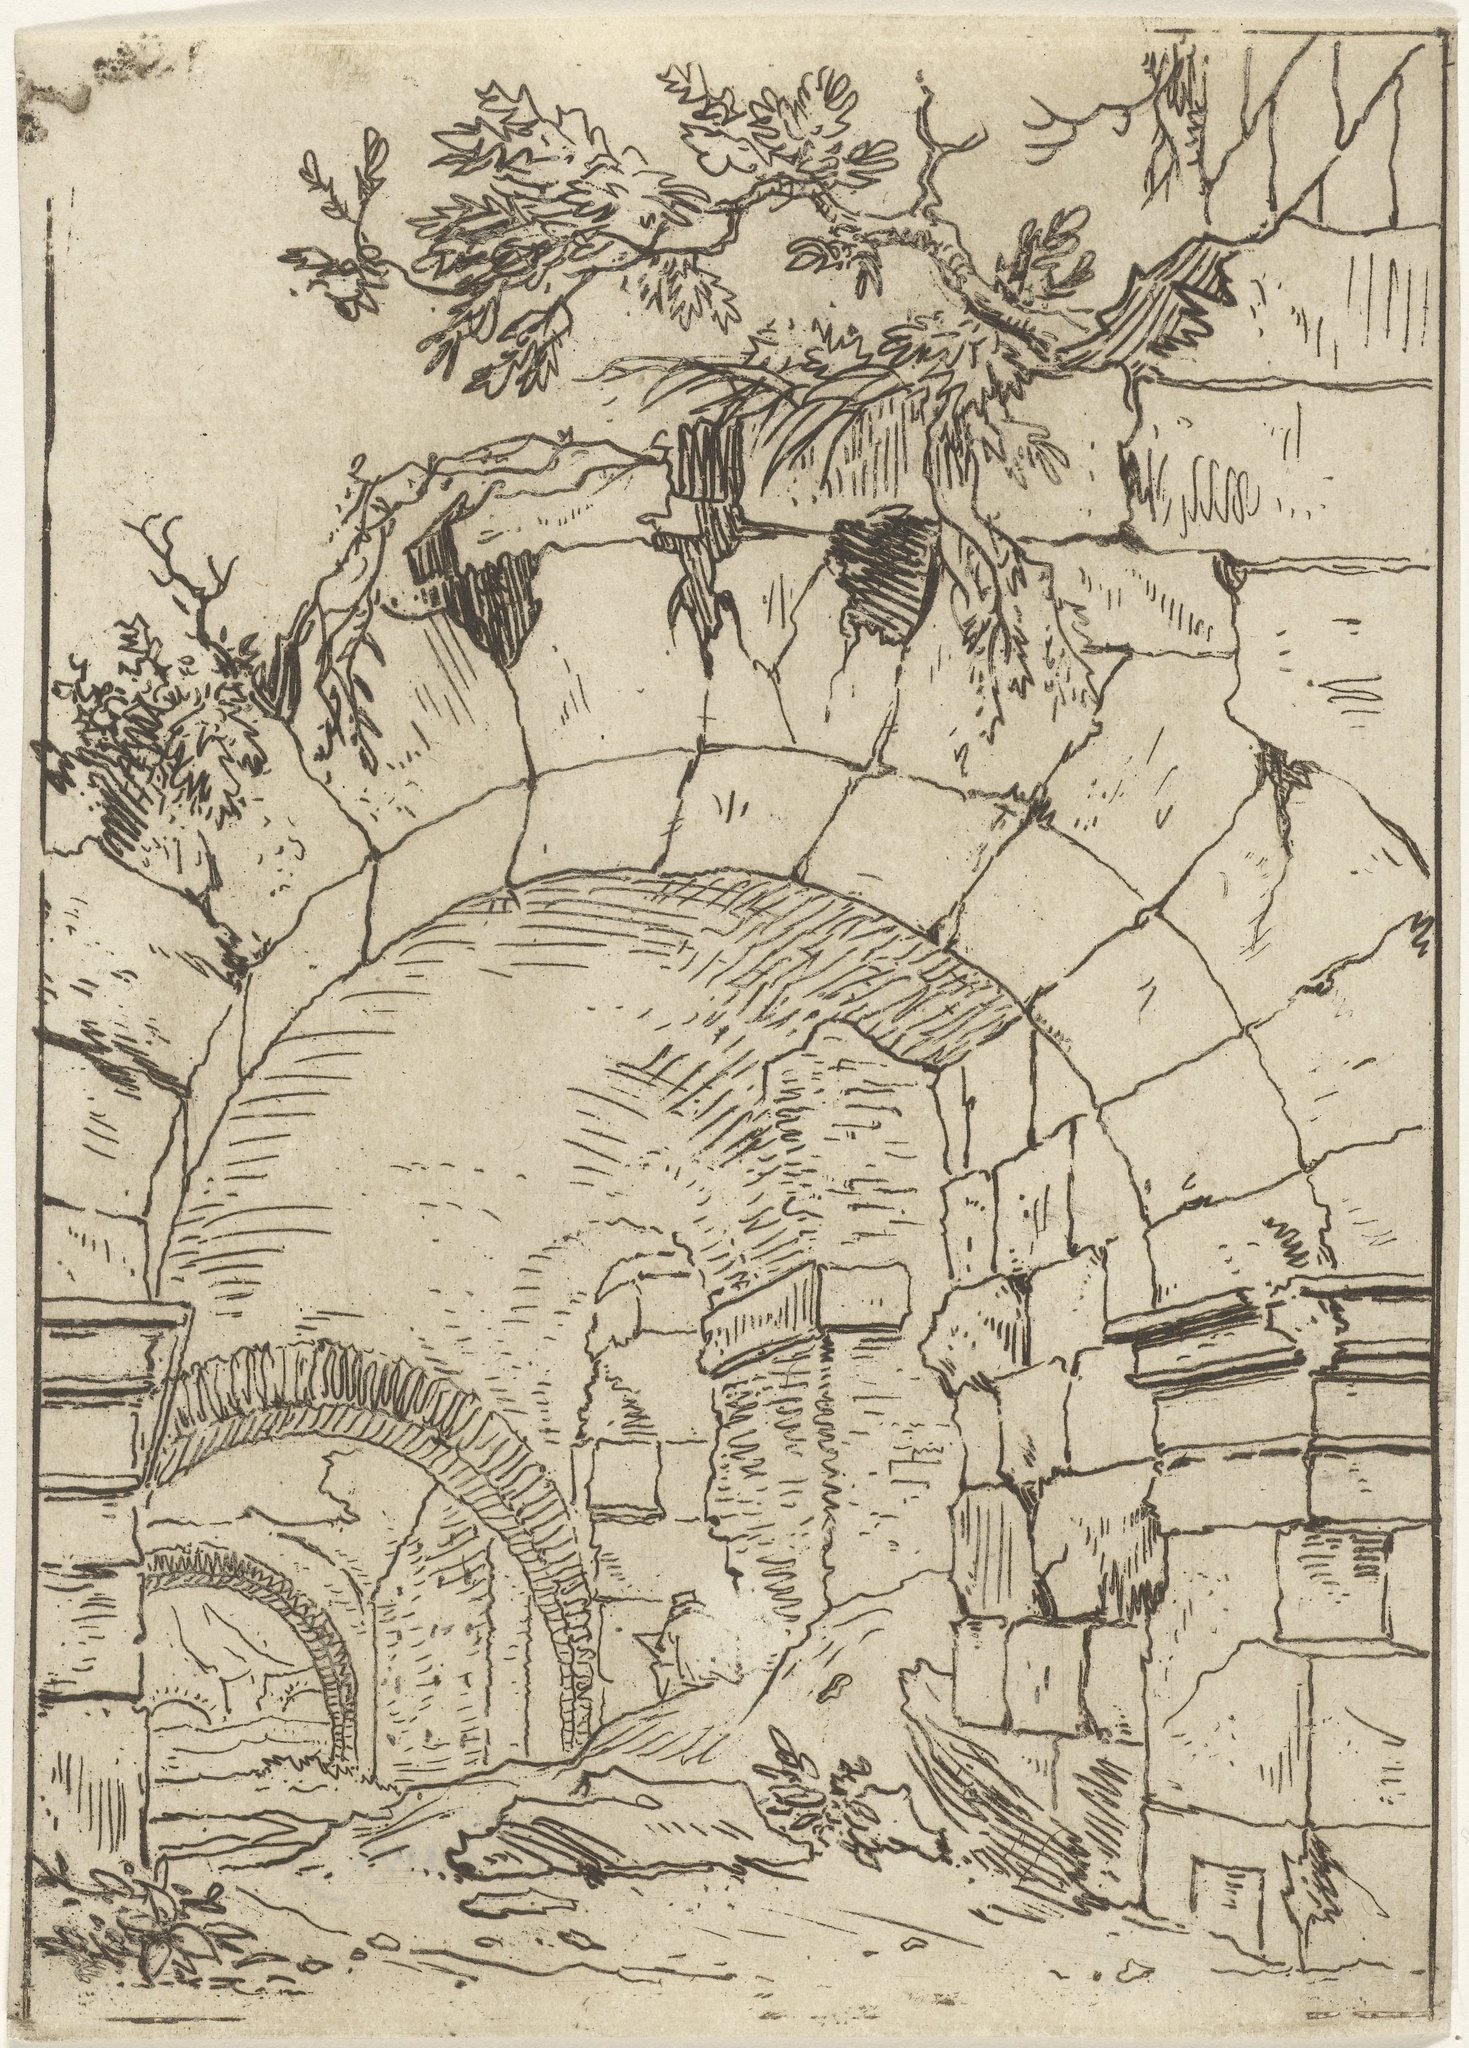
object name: print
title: Tekenaar in het Colosseum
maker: hermanus fock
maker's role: conservator, draughtsman, painter, print maker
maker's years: 1766-1822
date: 1781-1822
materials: paper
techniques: etching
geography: amsterdam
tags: ruin of a building ~ architecture (+ artist at work)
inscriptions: collector's mark: Lugt 2228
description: Gezicht op de tongewelven van een ruïne, waar halverwege een persoon met een schetsblad zit.